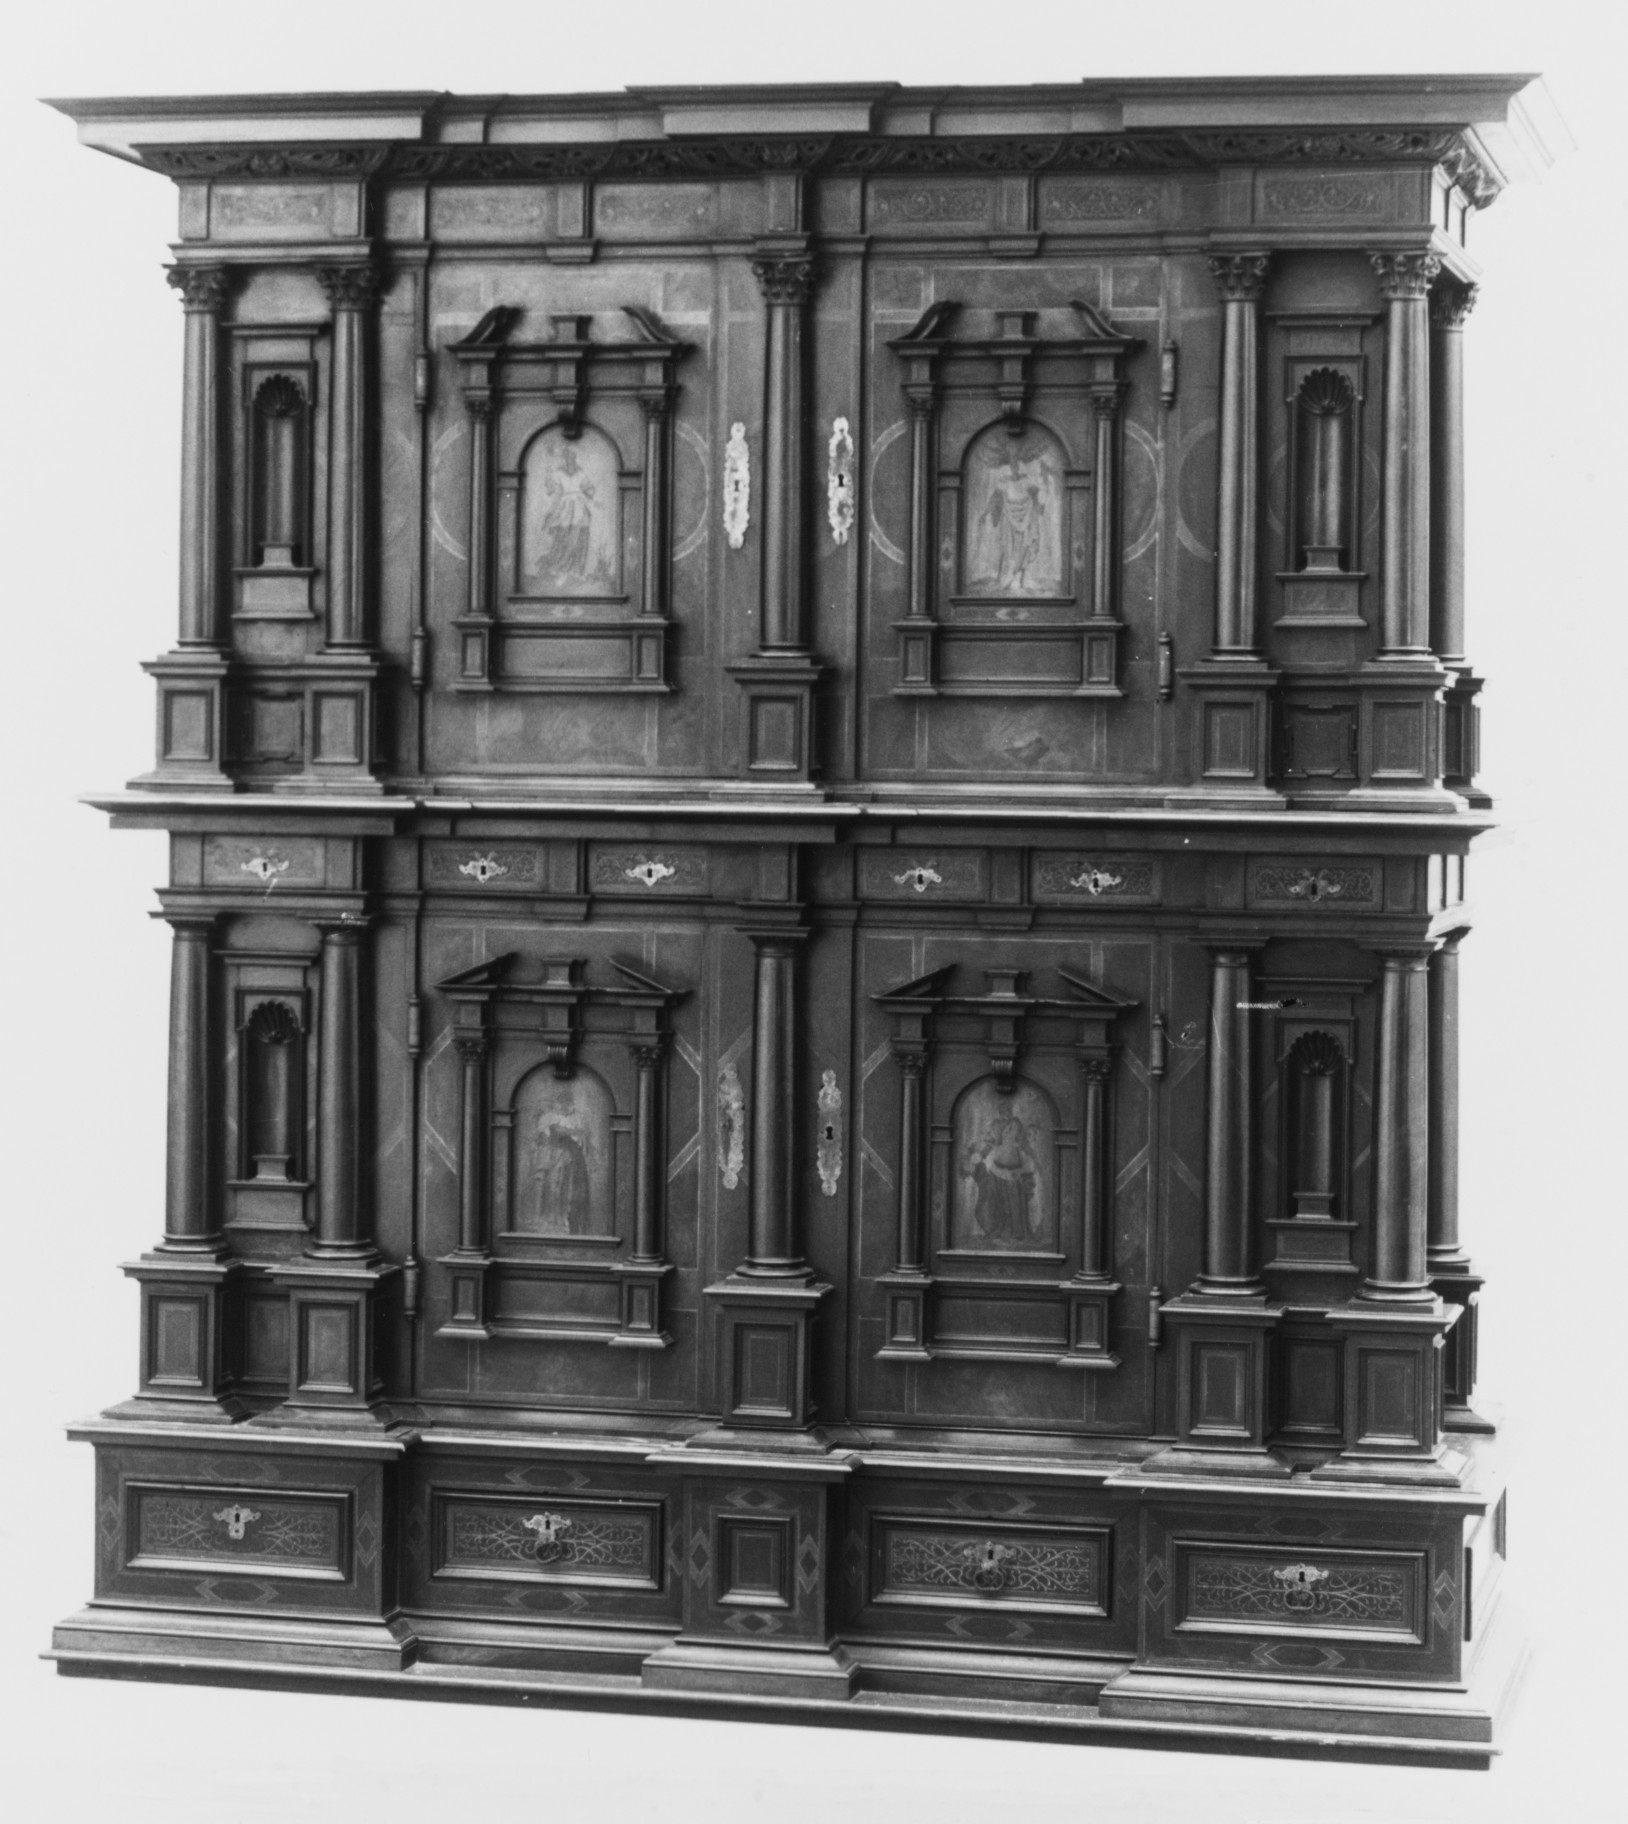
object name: cabinet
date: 1501-1600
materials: wood